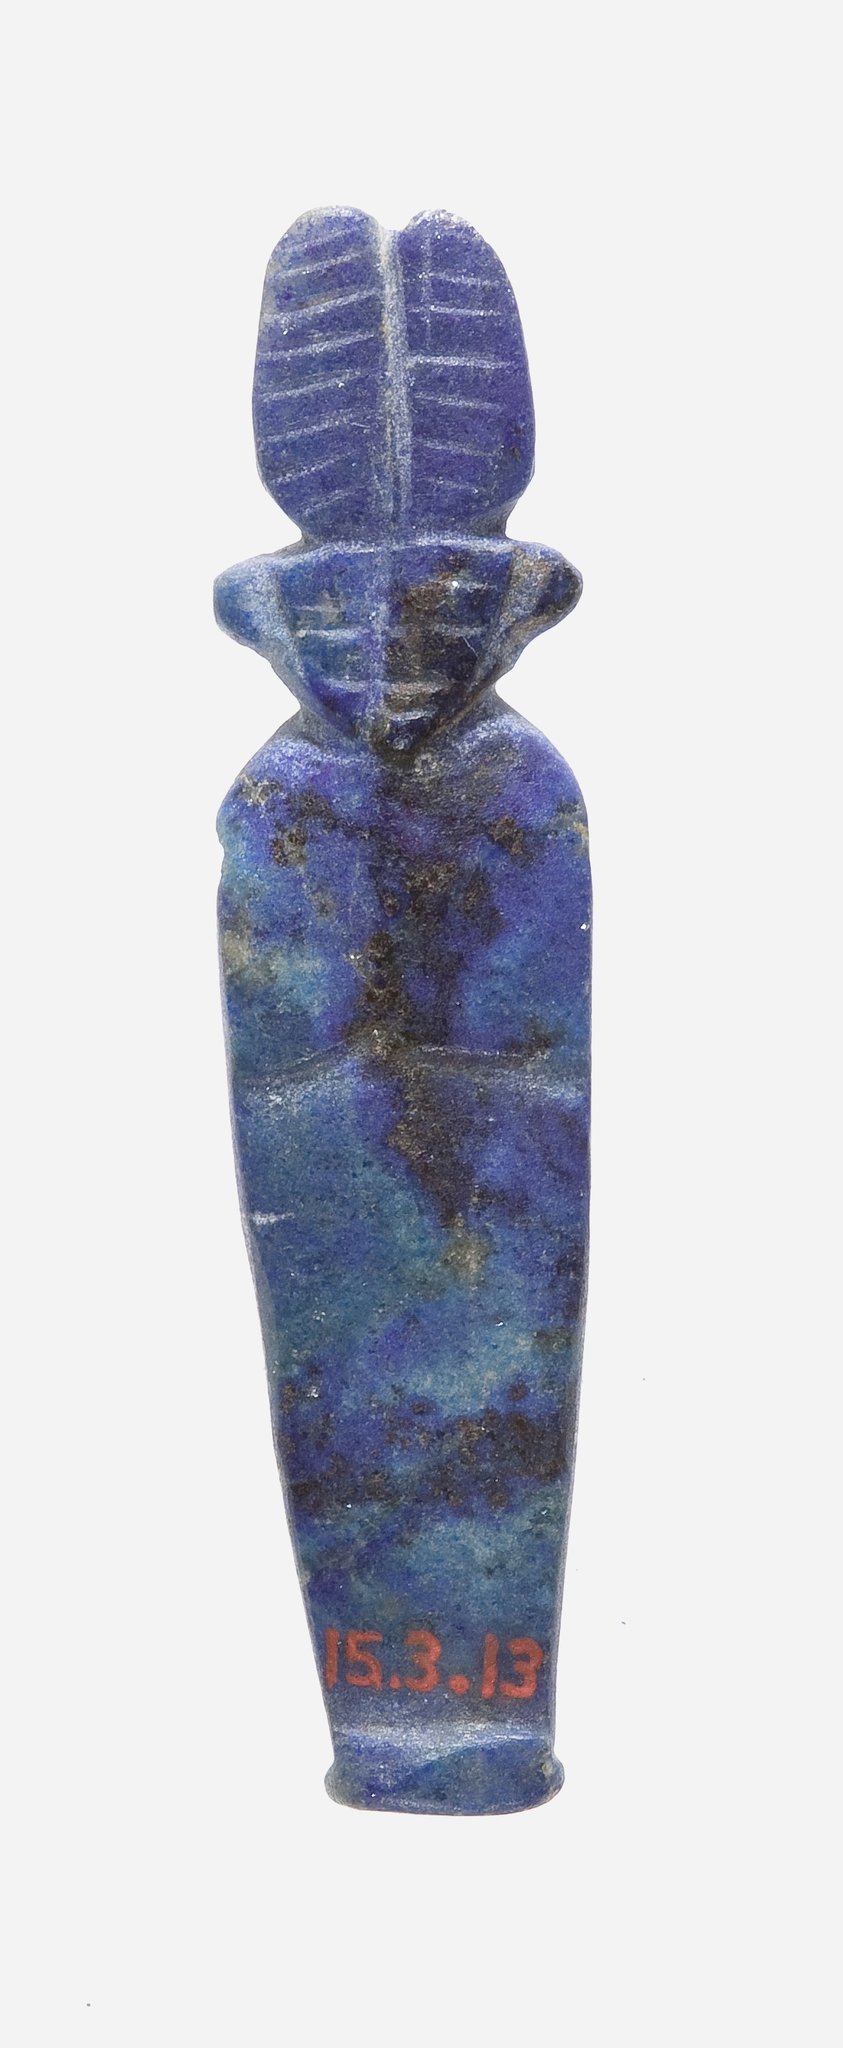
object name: necklace, bead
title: Amulet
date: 1981-1550 BCE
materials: lapis lazuli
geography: egypt